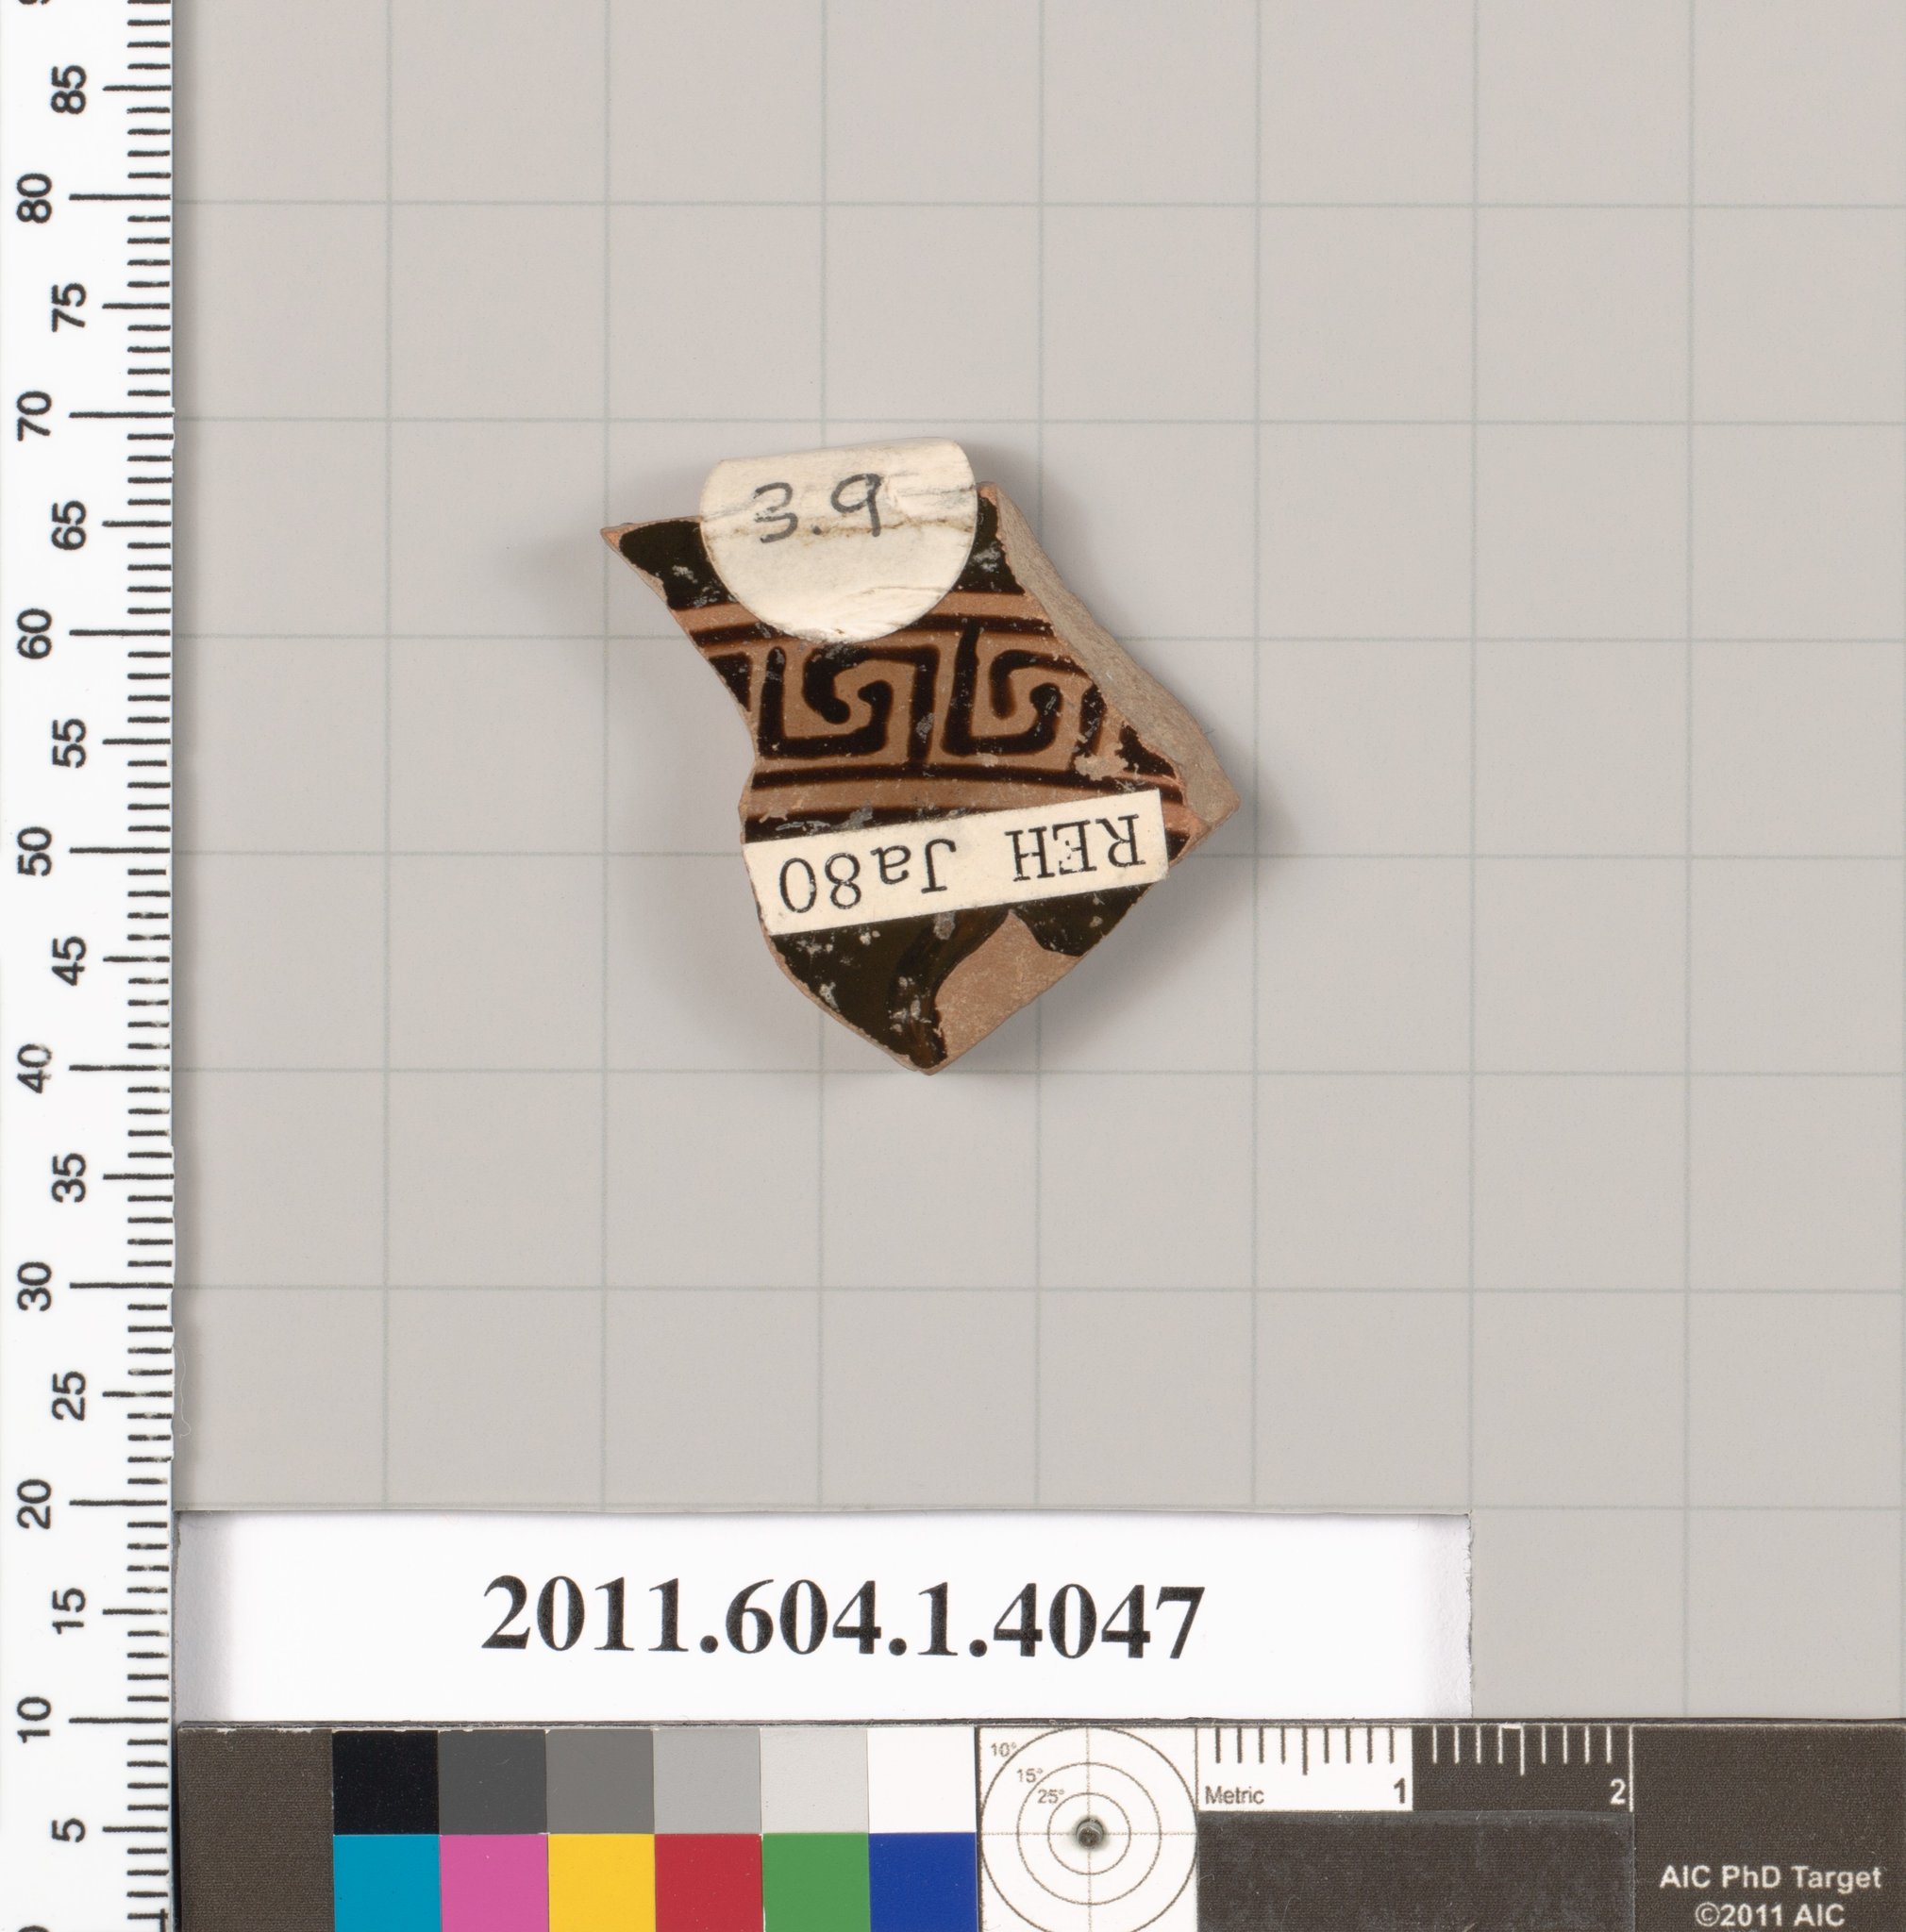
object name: kylix fragment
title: Terracotta fragment of a kylix (drinking cup)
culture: greek, attic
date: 500-476 BCE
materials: terracotta